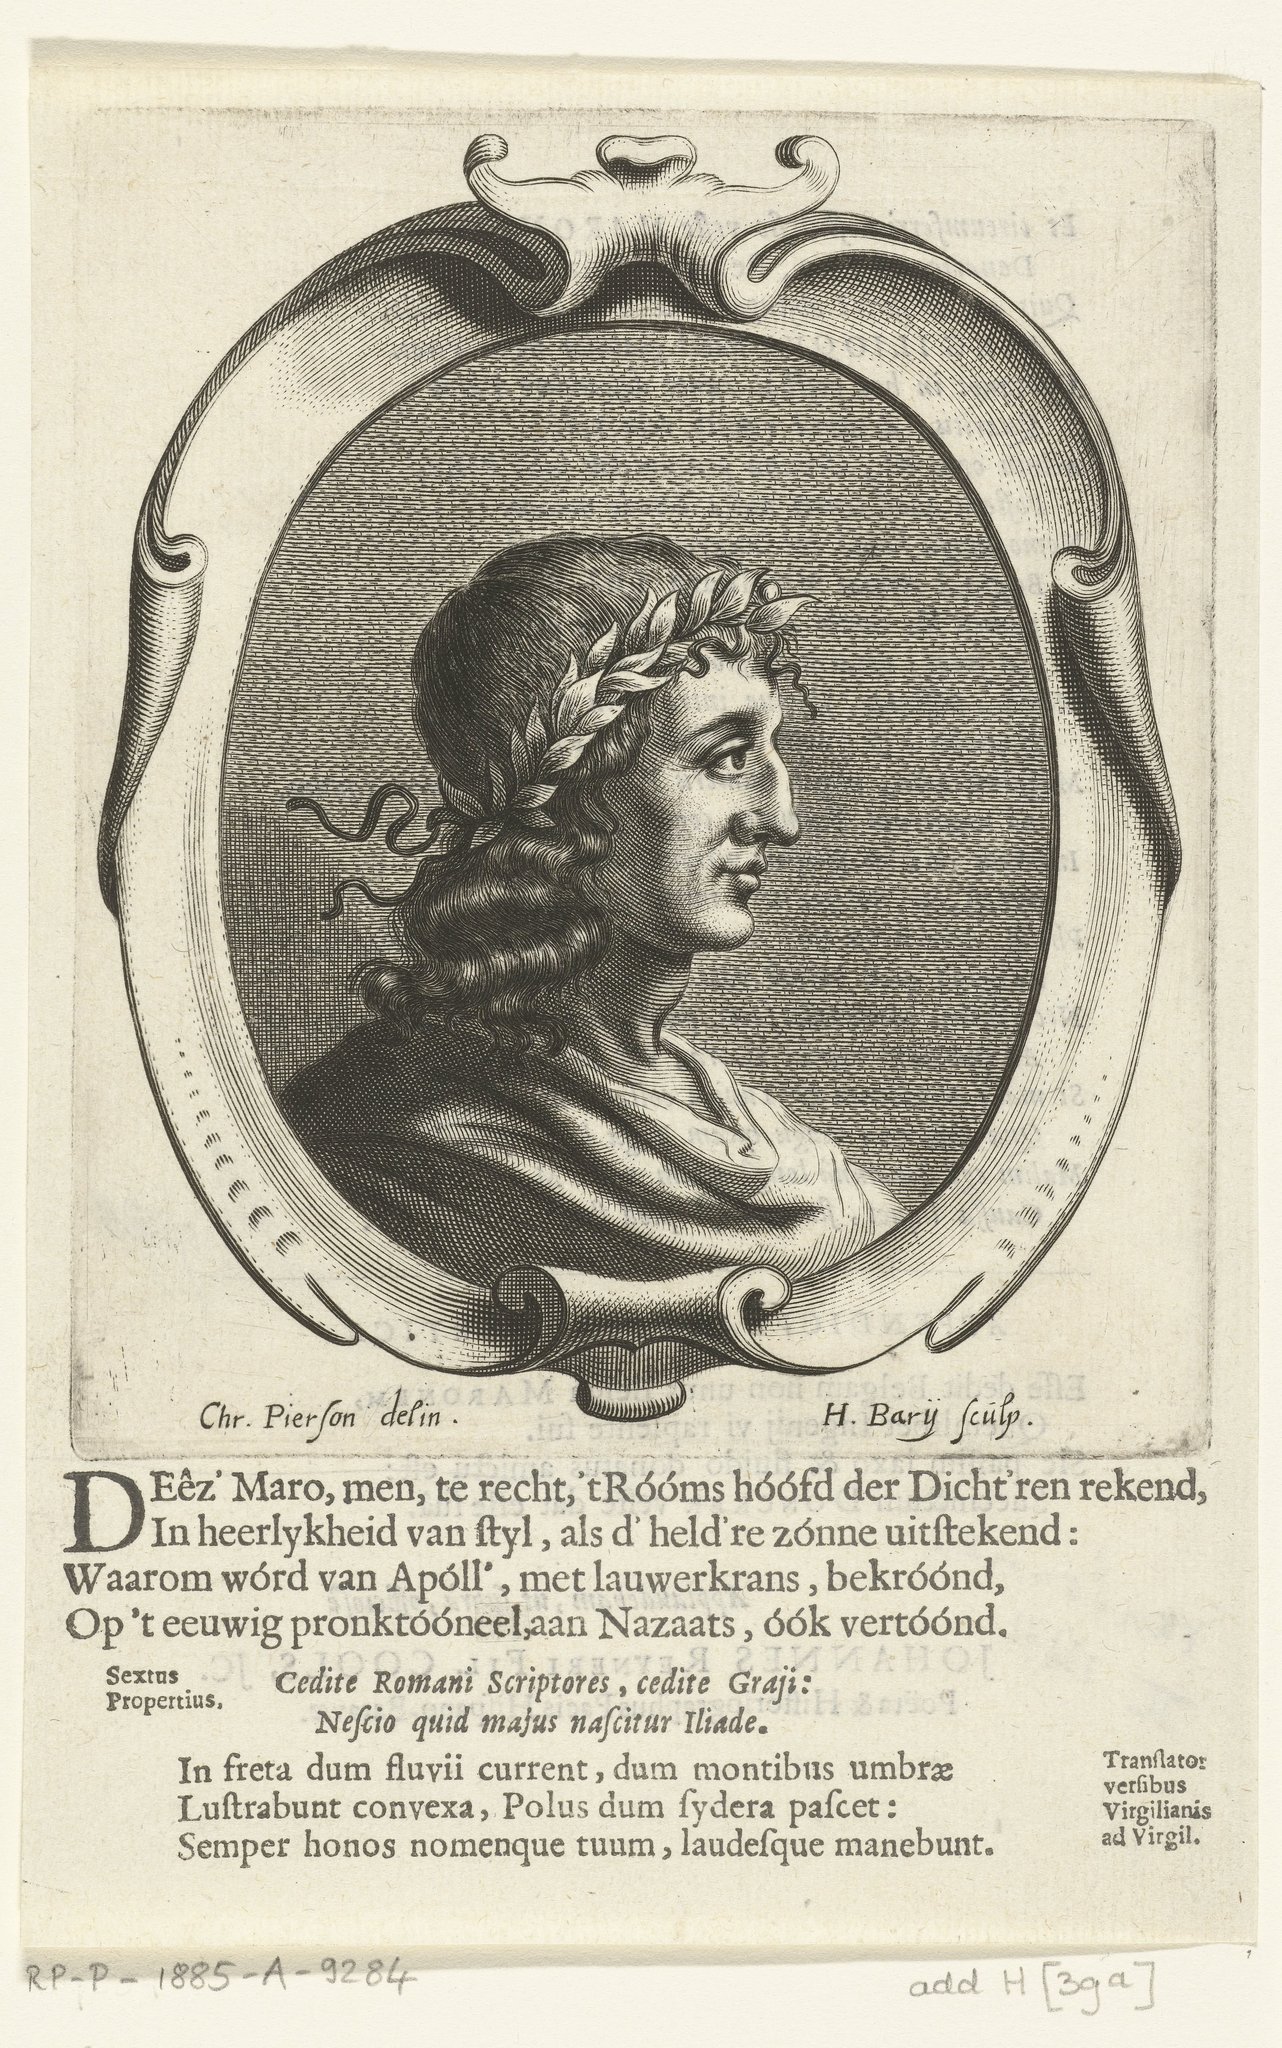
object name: print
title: Portret van Publius Vergilius Maro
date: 1657-1707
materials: paper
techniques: engraving, letterpress printing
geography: netherlands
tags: publius vergilius maro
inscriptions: collector's mark: Lugt 2228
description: handgeschreven addenda op Hollstein in exemplaar bibliotheek RMA: add H [39a]. mogelijk bladzijde uit een boek van Publius Vergilius Maro vertaald door D. Doncker: Herders-kouten en land-gedichten: midsgaders de XII. boecken van Æneas, Gouda, verschillende edities.